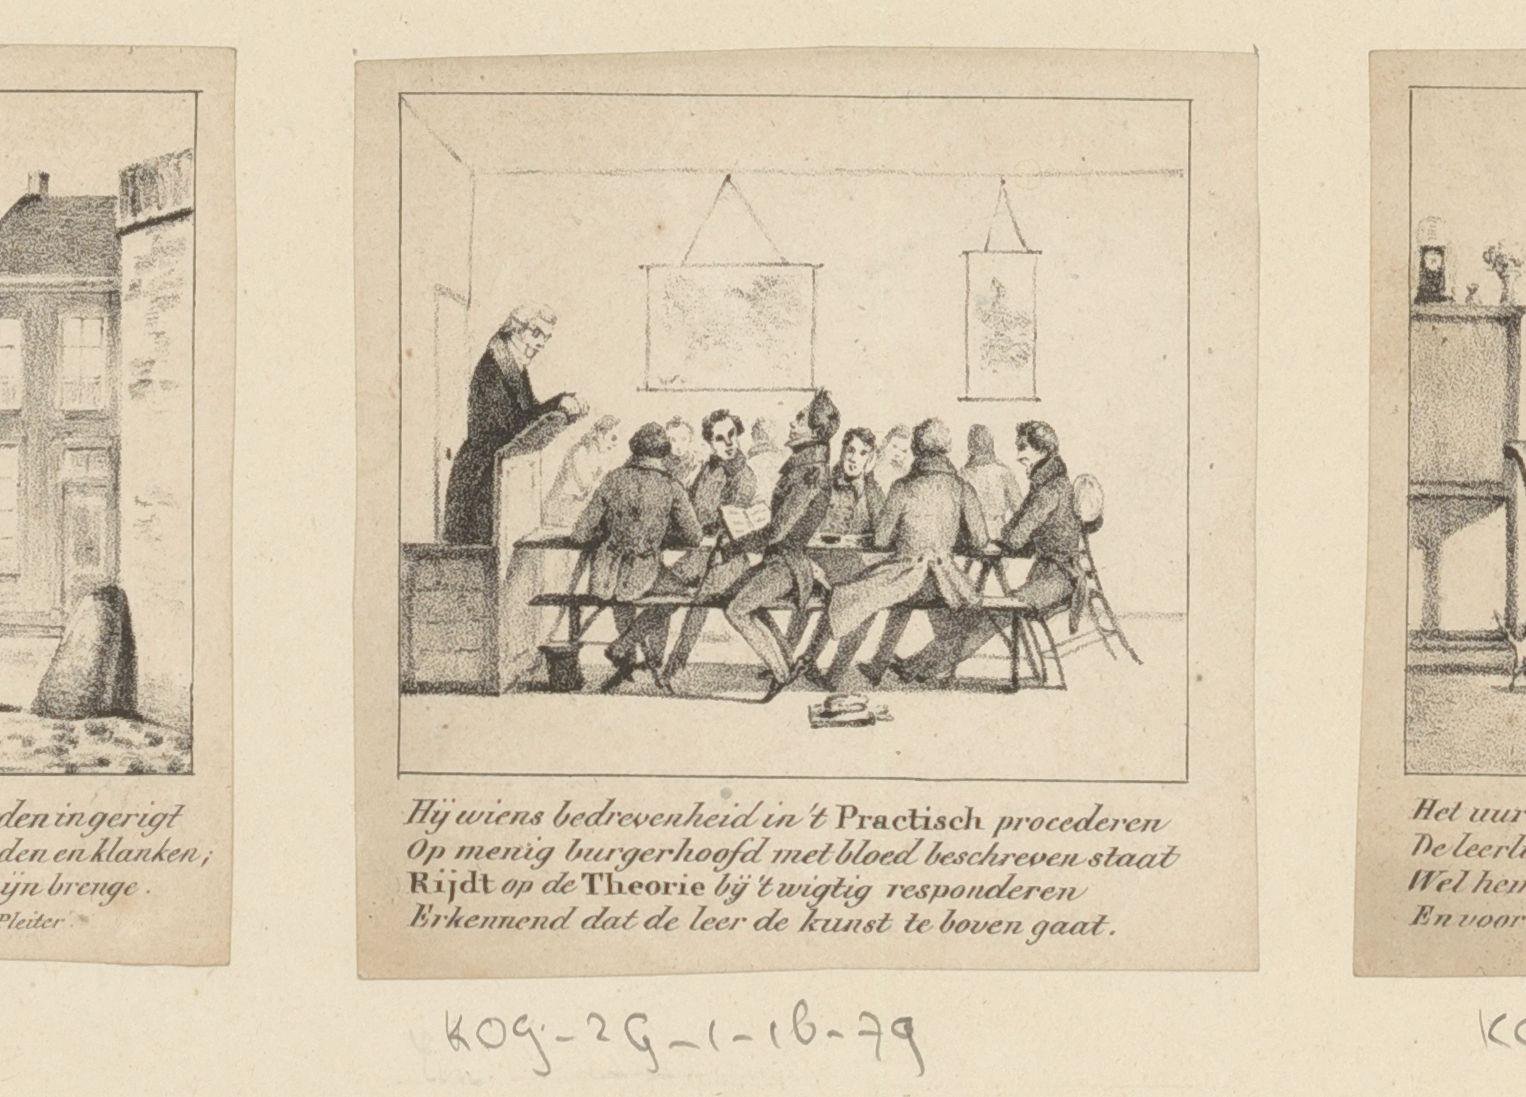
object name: print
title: Studenten tijdens een college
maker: Anonymous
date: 1835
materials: paper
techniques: lithograph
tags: lecture ~ university, student life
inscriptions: stamp, stamp, collector's mark: Lugt 1641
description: Prent mogelijk geknipt uit een grotere prent met de titel op object: Stichtsche School-prent. Prent gepubliceerd bij: Utrechtsche Studenten almanak. Utrecht: J. van Druten, 1885.